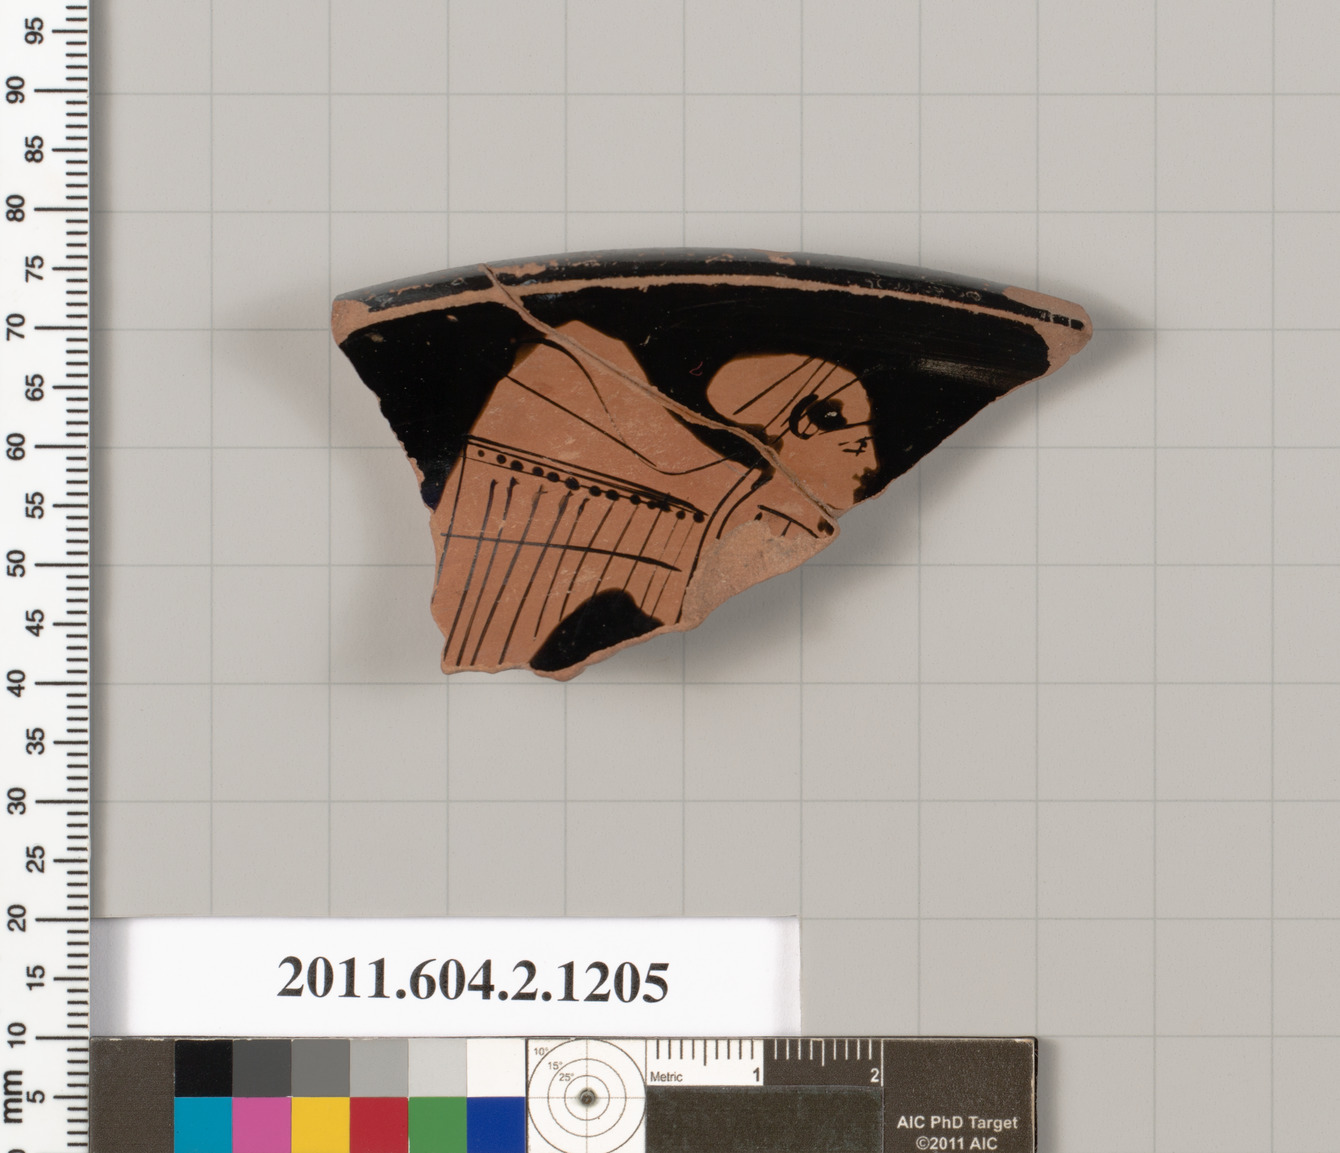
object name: kantharos fragment, head vase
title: Terracotta fragment from a kantharos: head vase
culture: greek, attic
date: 467-435 BCE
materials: terracotta